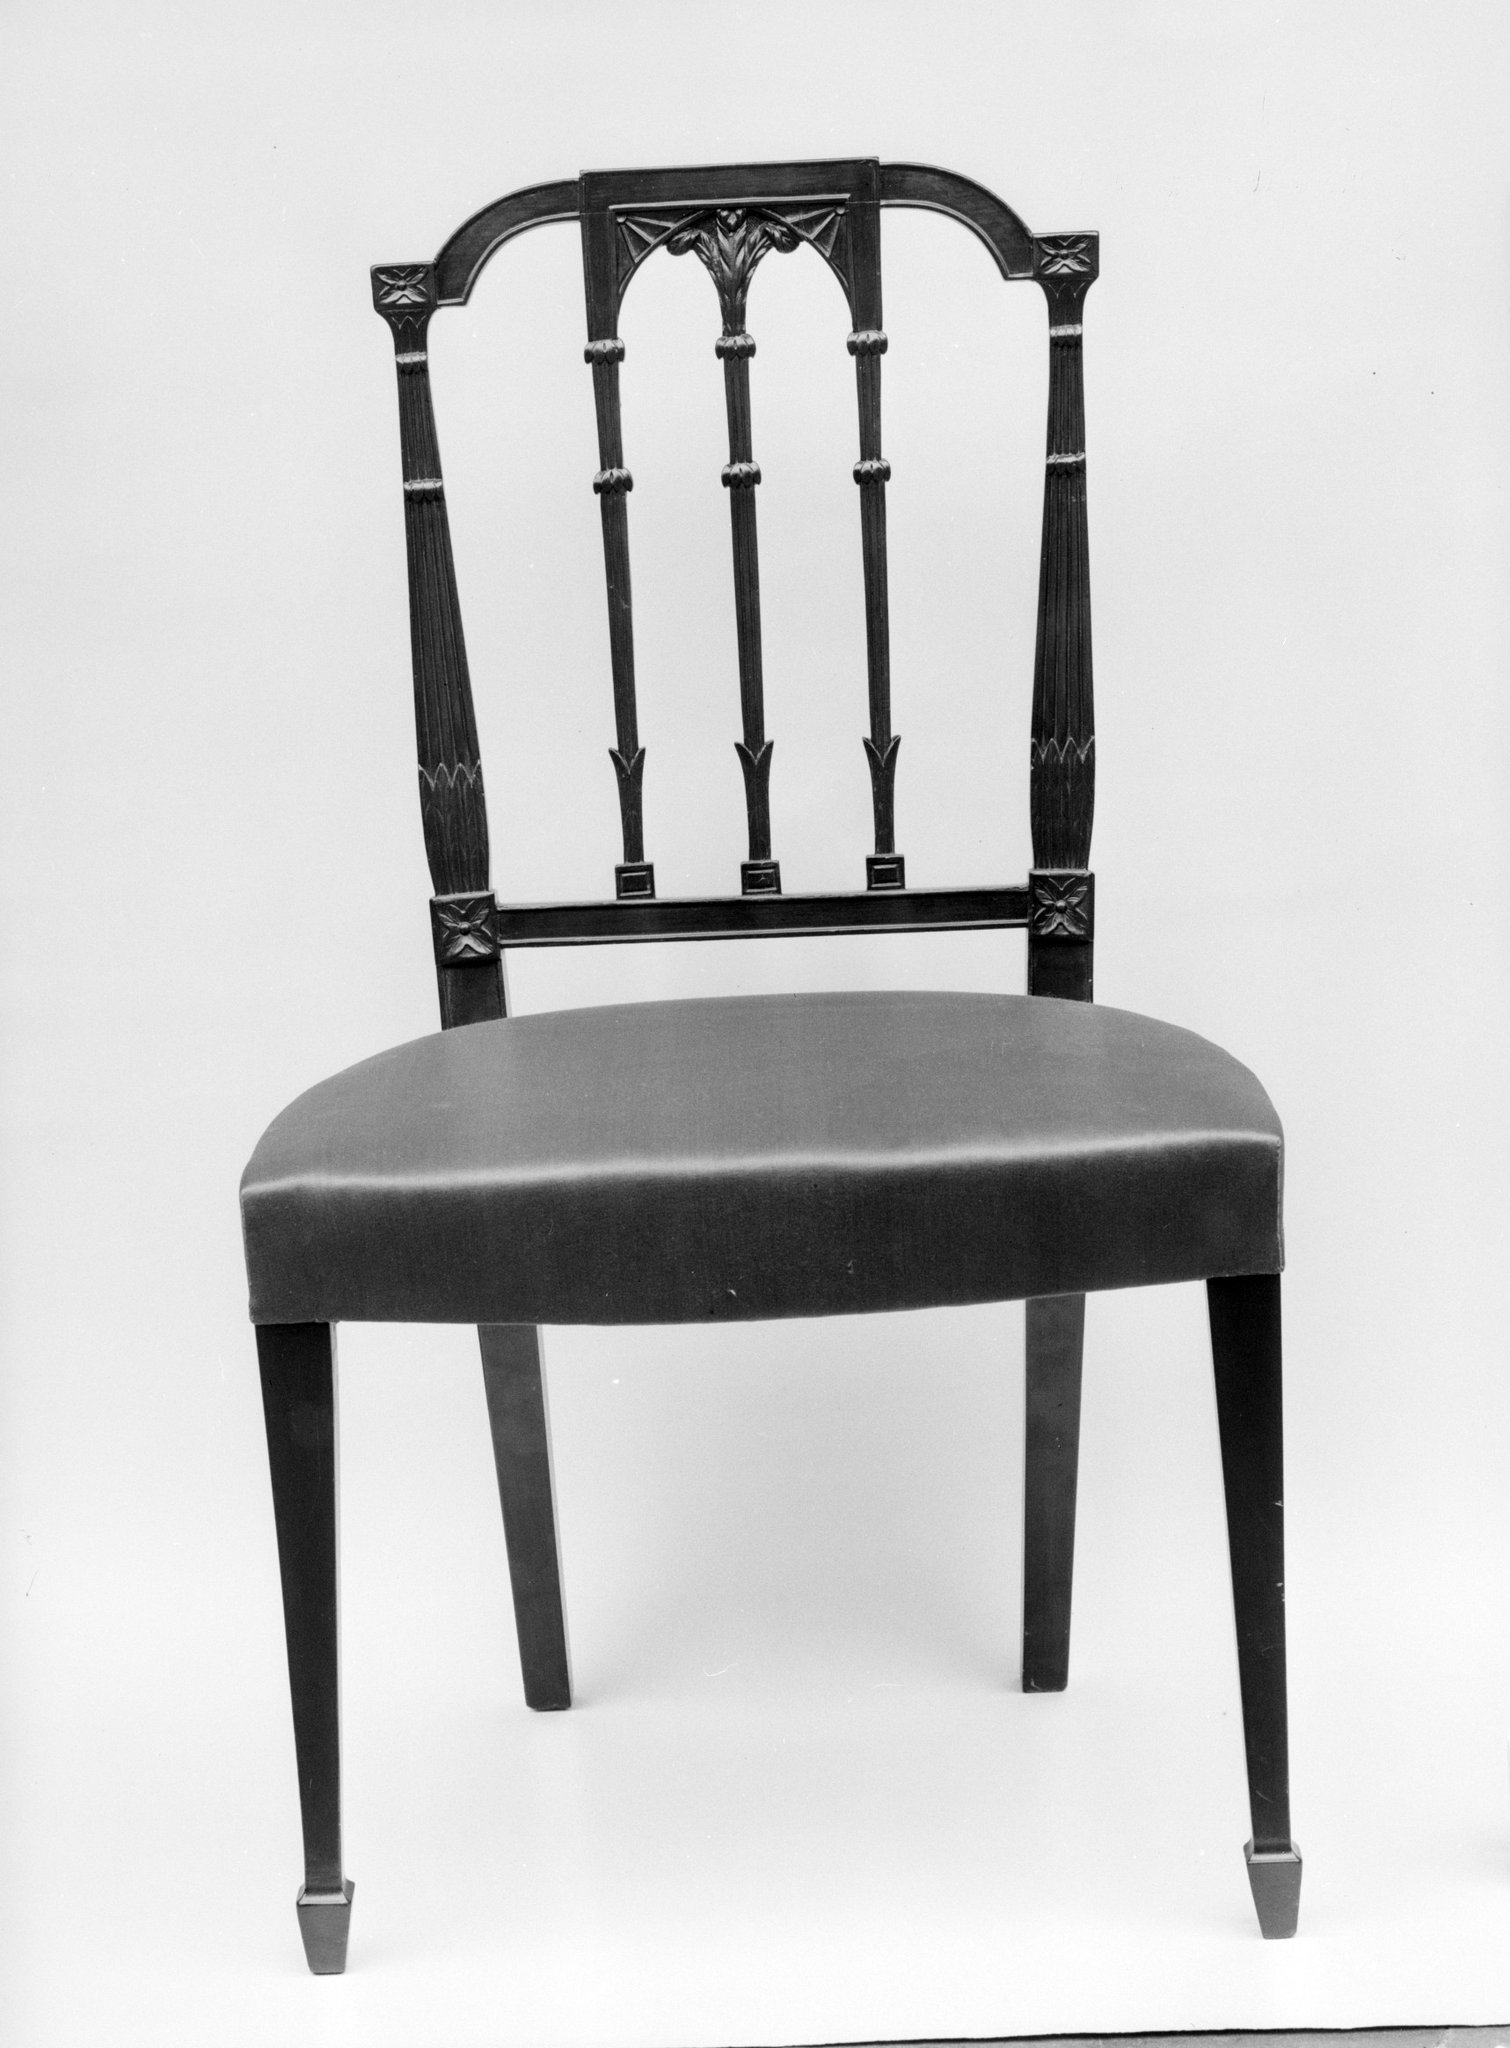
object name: side chair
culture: american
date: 1795-1810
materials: wood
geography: united states